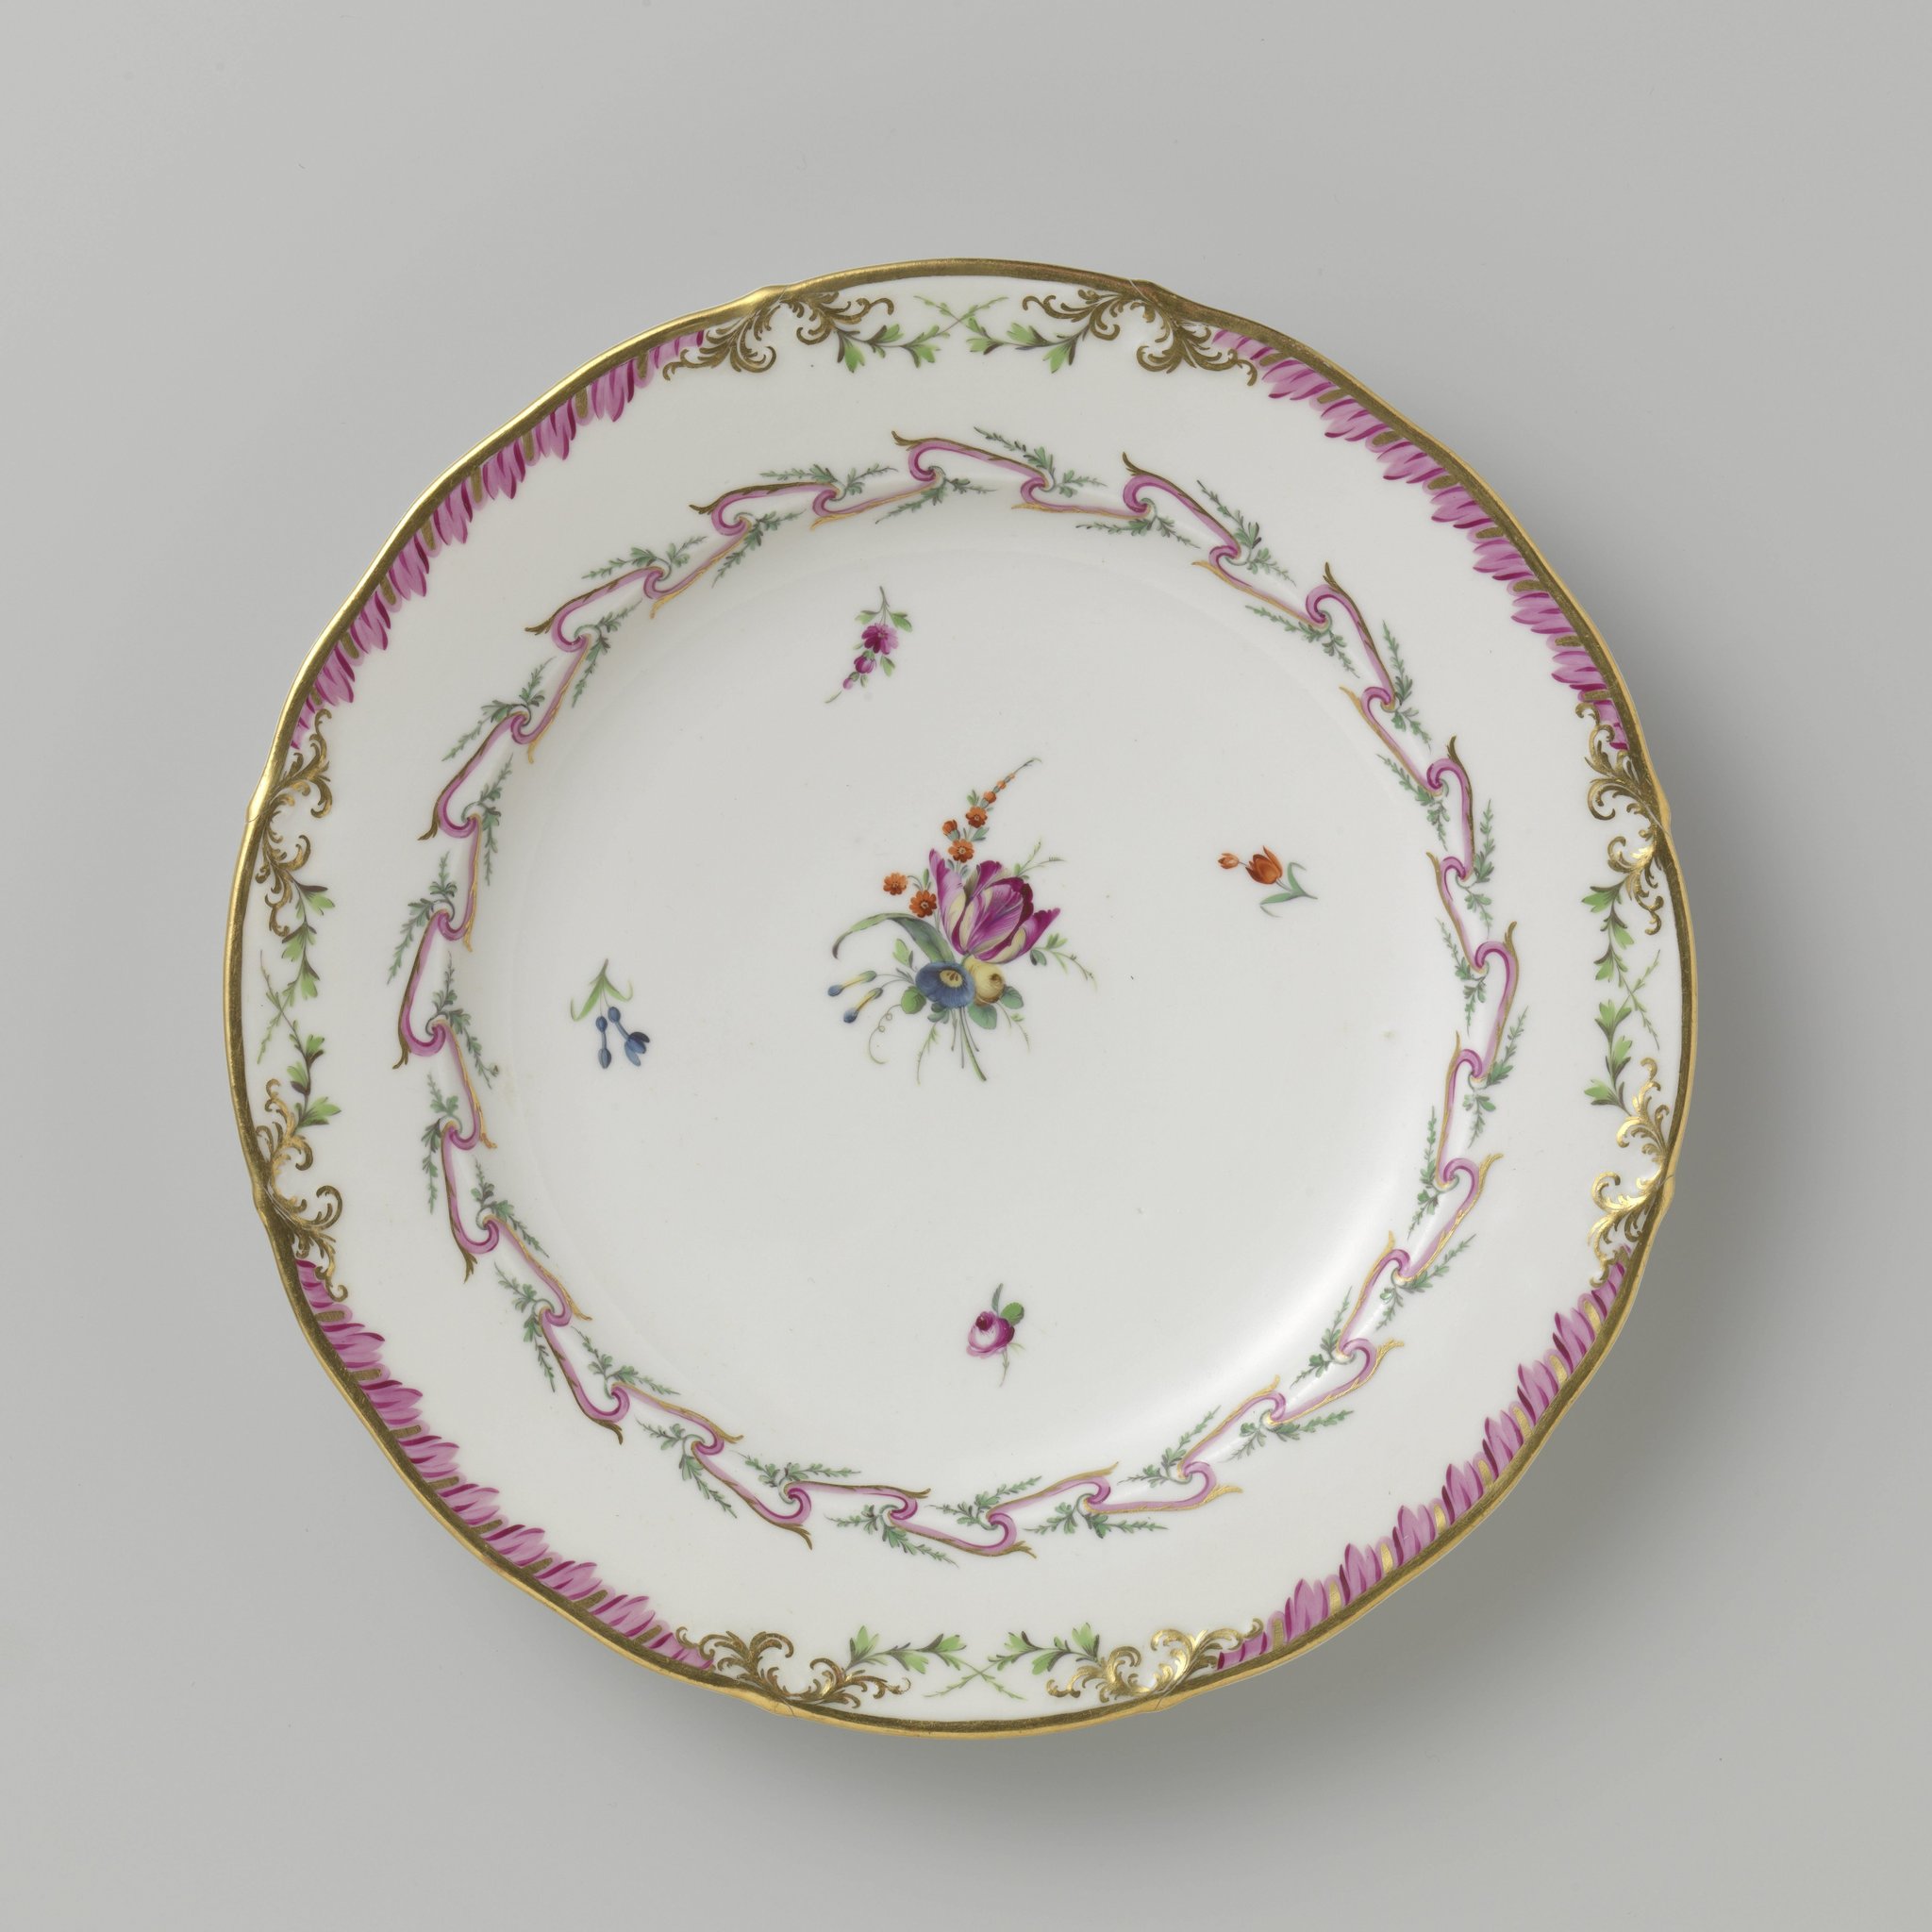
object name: plate dish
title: Sauceboat, cream pots and plate, part of a service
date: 1784-1809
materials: porcelain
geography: loosdrecht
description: Porceleinfabriek aan den Amstel Manufactuur Oud-Loosdrecht Ouder-Amstel and Loosdrecht, c. 1784-1809 hard-paste porcelain